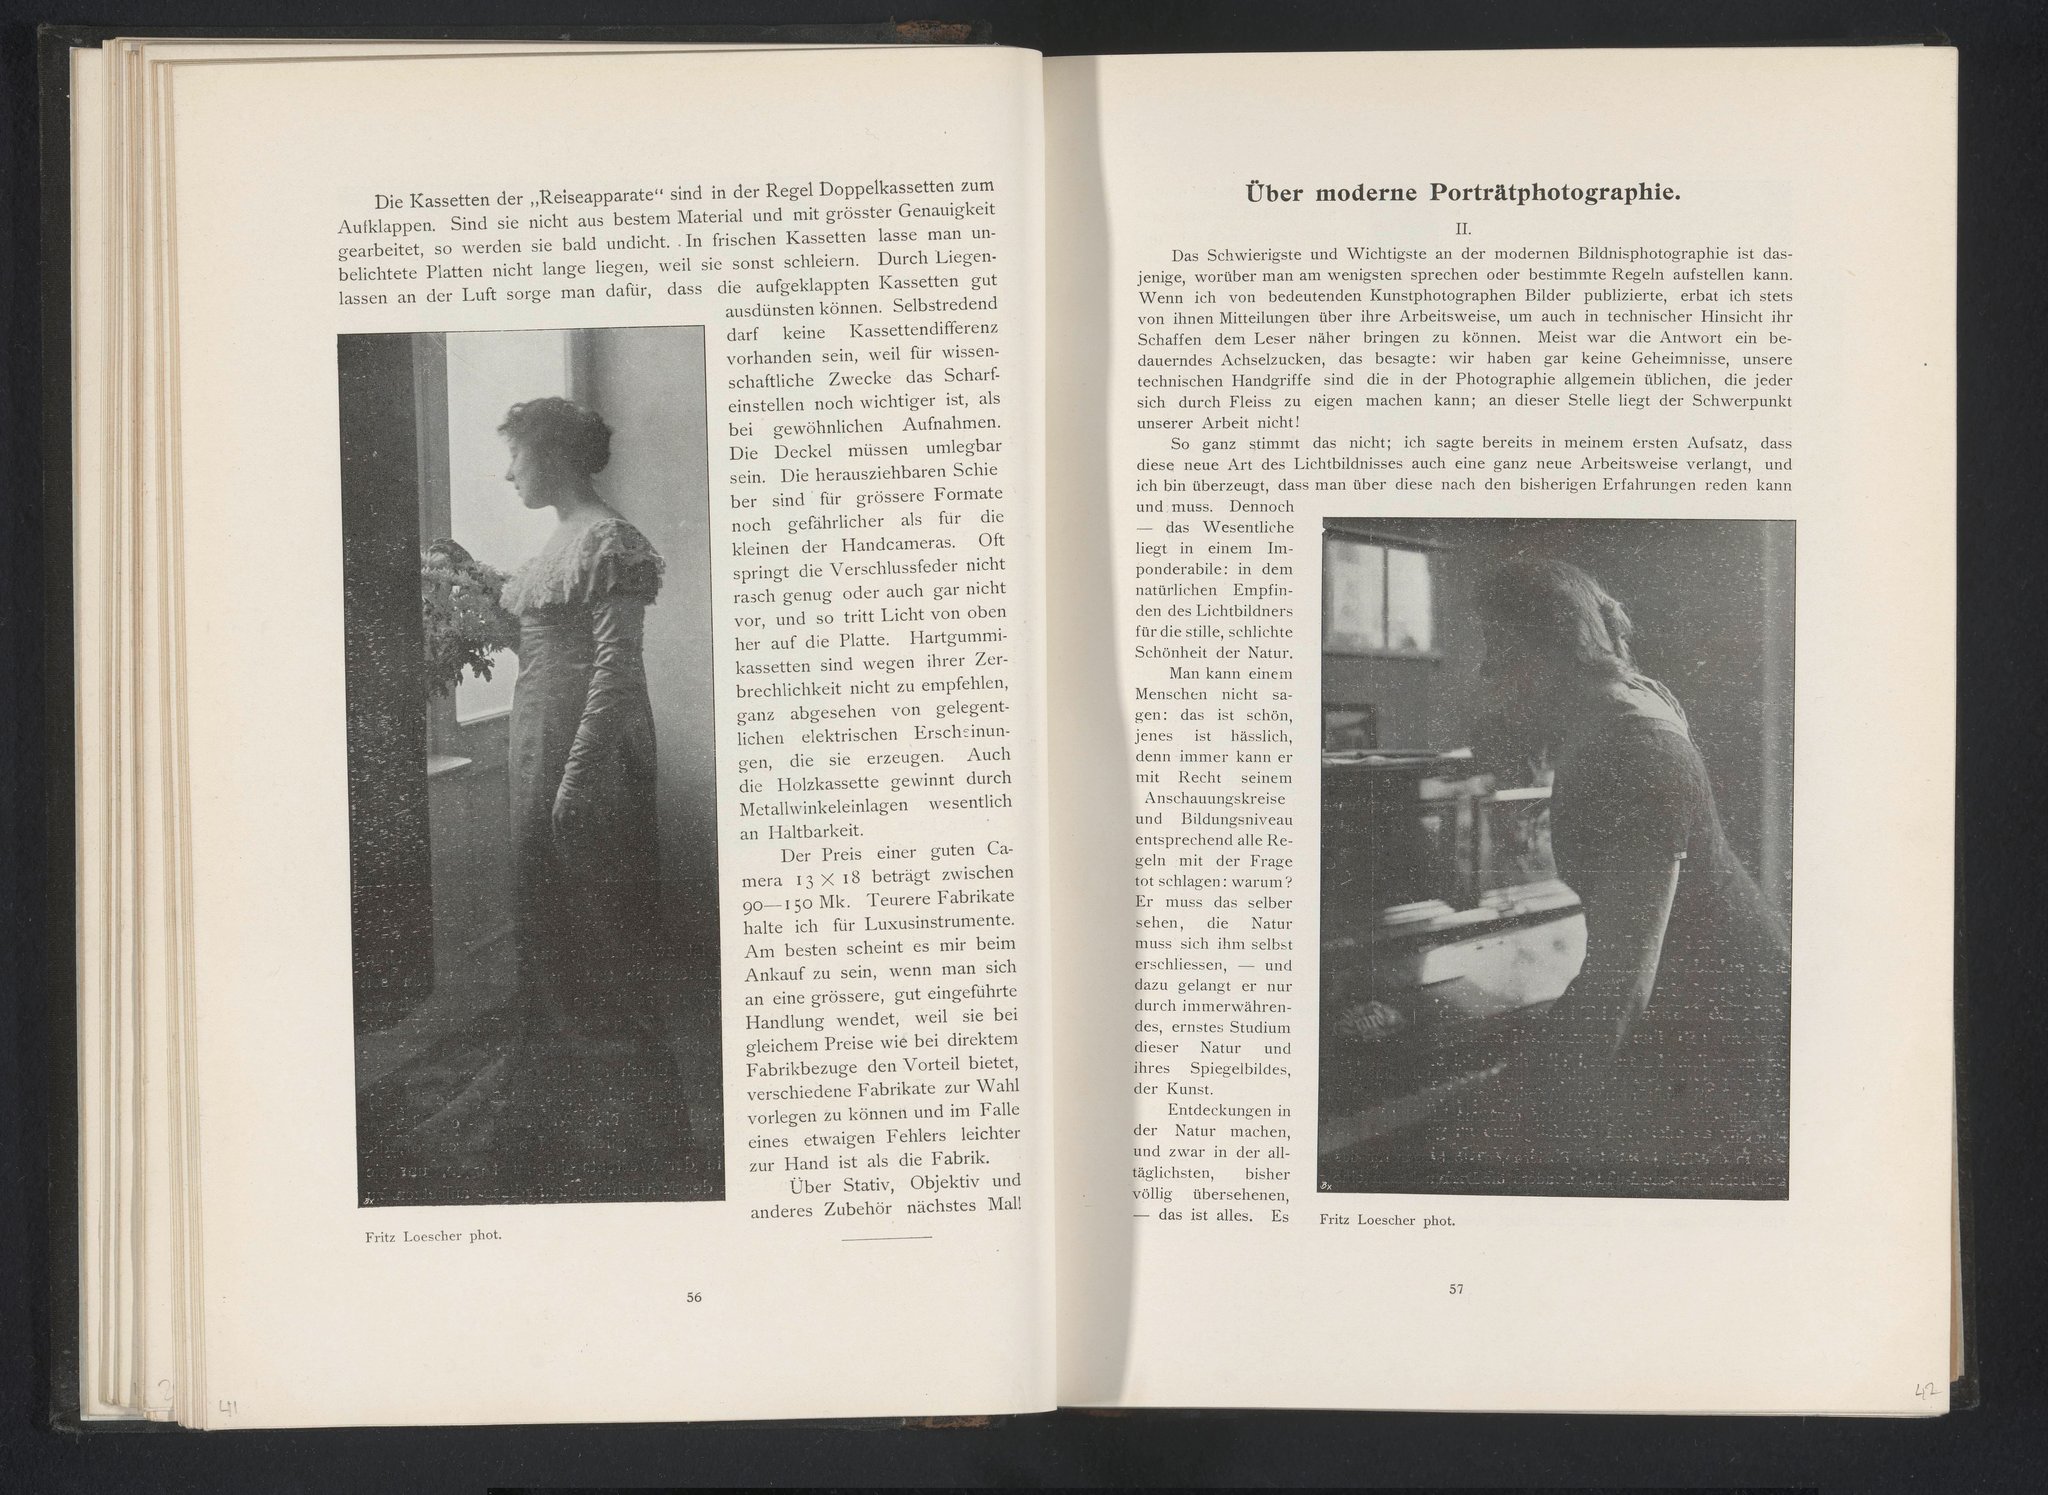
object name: page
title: Portret van een onbekende vrouw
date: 1898-1903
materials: paper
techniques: autotype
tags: historical persons - bb - woman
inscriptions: monogram: ‘BX’